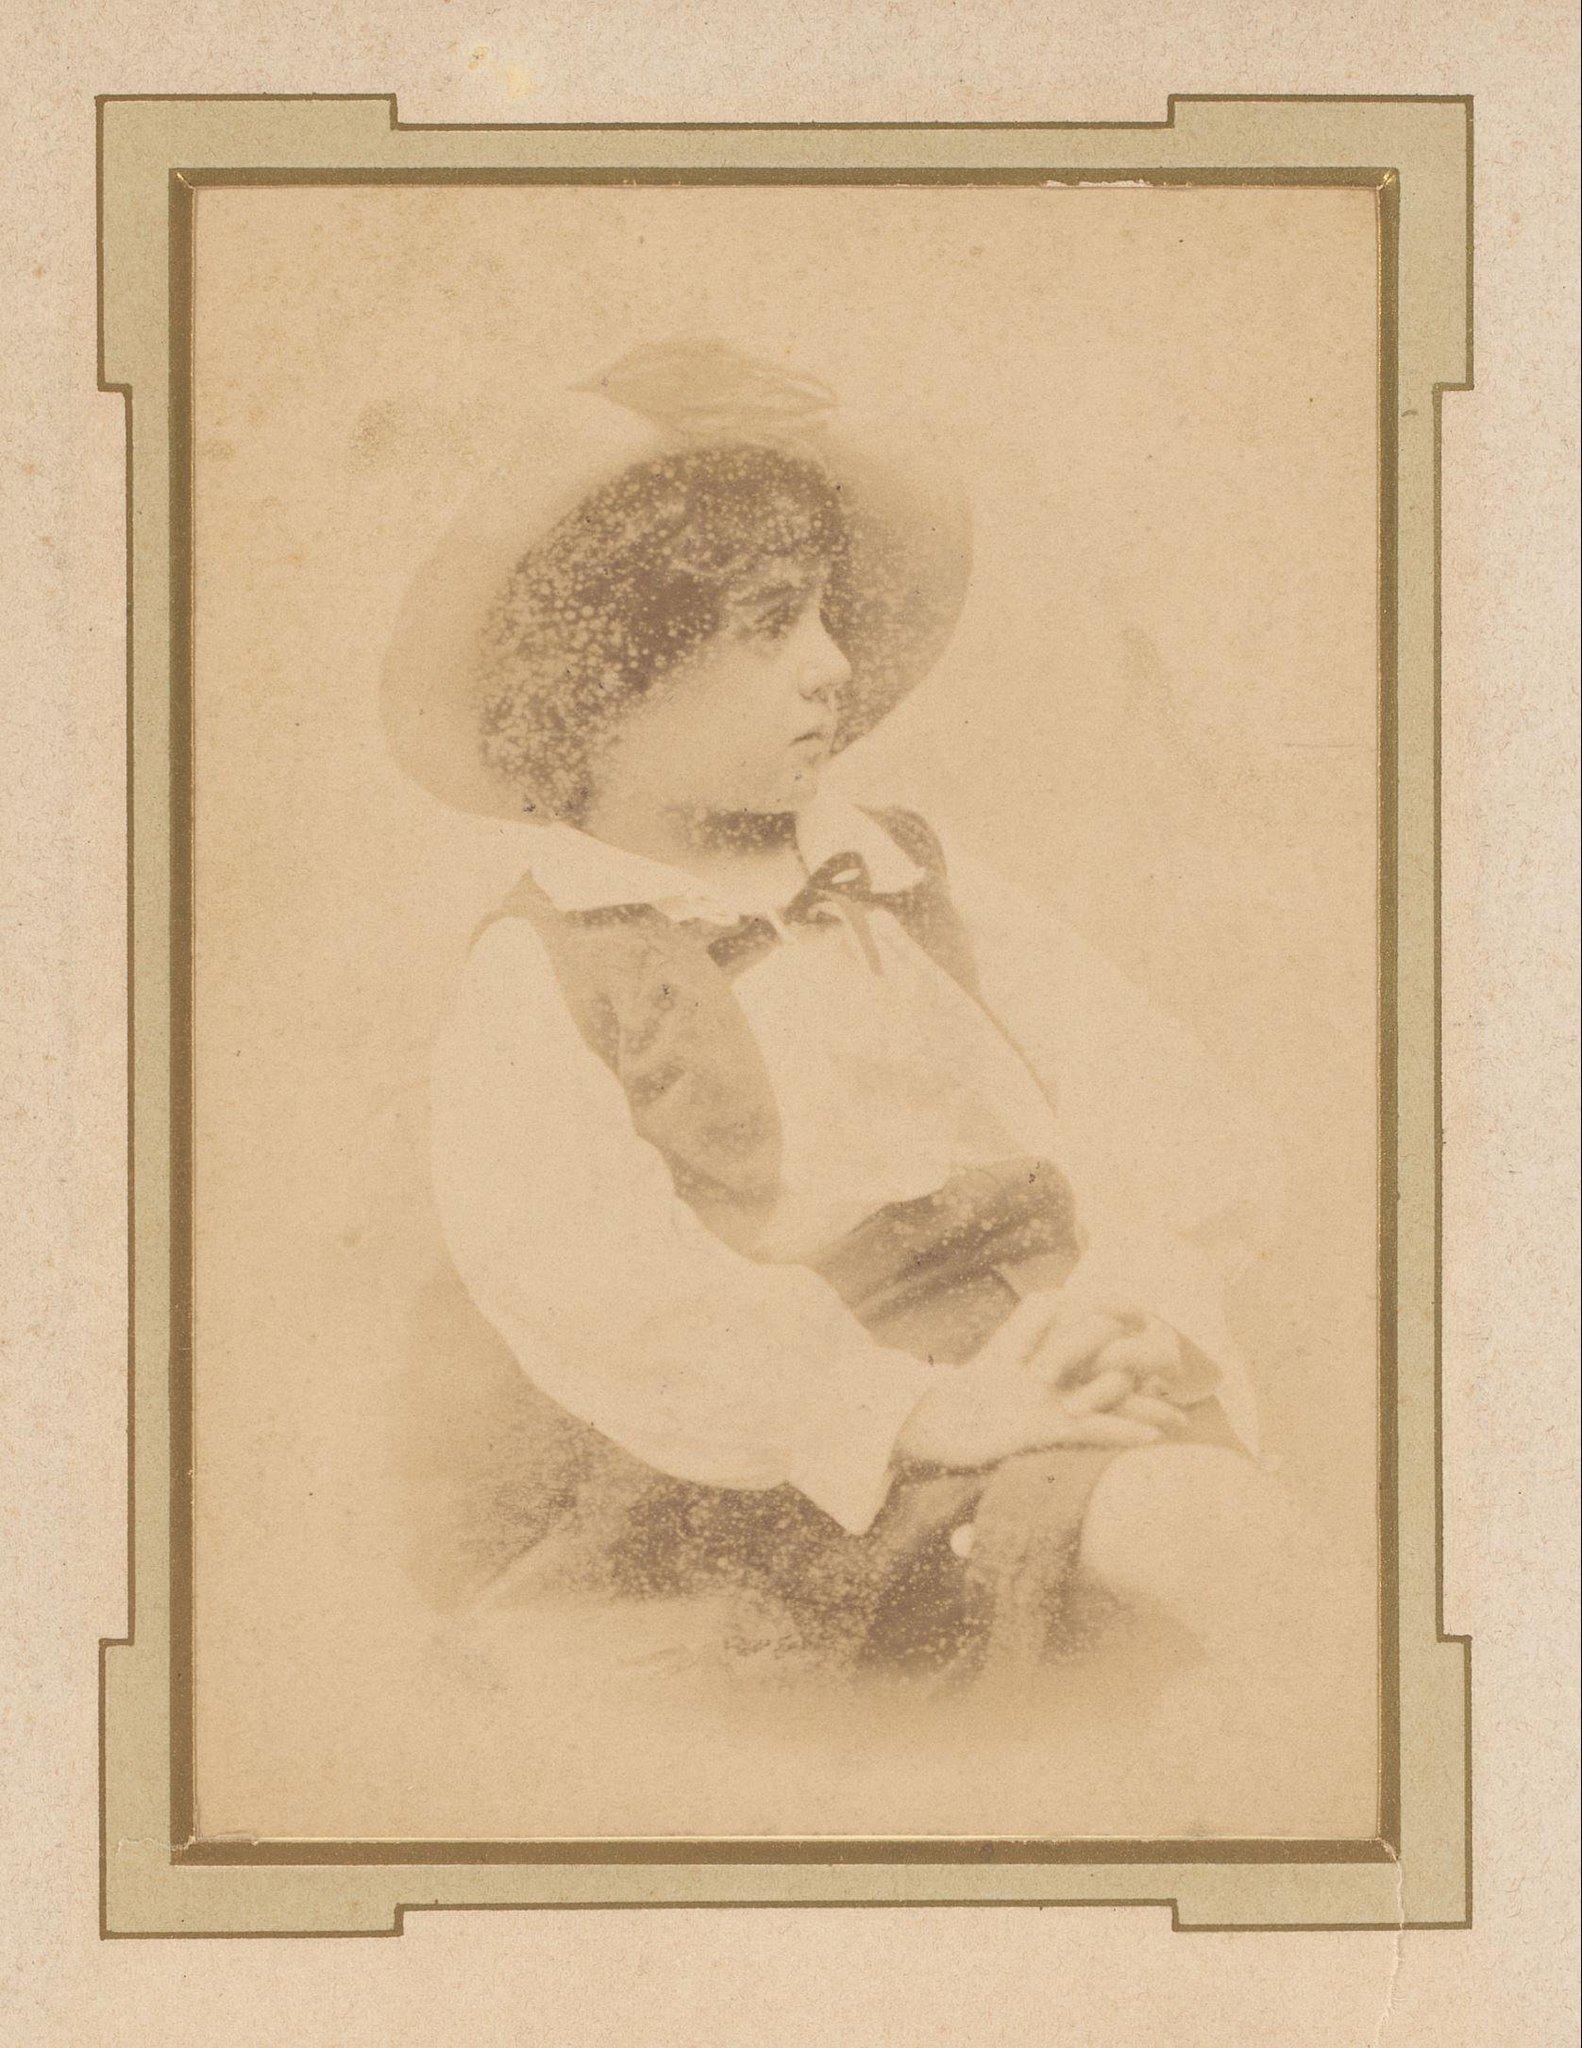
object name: photograph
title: Portret van een zittende jongen met hoed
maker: Anonymous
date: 1883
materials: cardboard, photographic support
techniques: albumen print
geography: frankfurt am main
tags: boy (child between toddler and youth), head-gear: hat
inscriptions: inscription: ‘Nach der Natur afgen. 1883. Vervielfältigung vorbeh./ Jacquino/ Verlagsanstalt für Kunst und Wissenschaft vormals Friedrich Bruckmann in München’